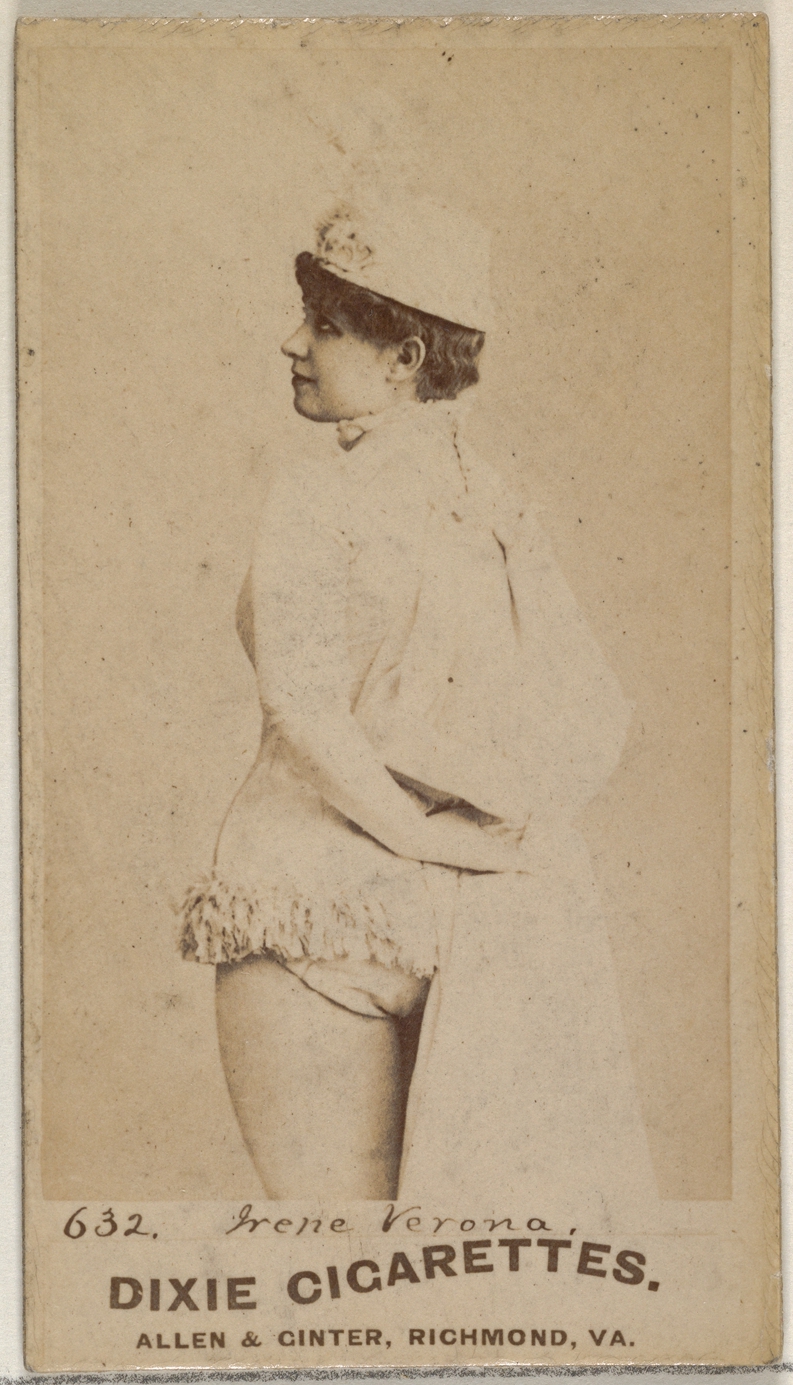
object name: photograph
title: Card 632, Irene Verona, from the Actors and Actresses series (N45, Type 7) for Dixie Cigarettes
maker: allen & ginter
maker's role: publisher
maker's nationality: american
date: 1888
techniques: albumen silver print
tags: portraits,profiles,women,actresses